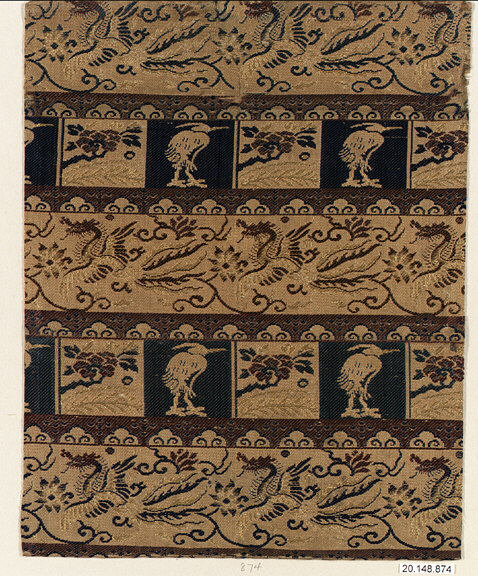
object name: piece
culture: chinese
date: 1701-1800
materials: silk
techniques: compound weave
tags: birds,mythical creatures,flowers